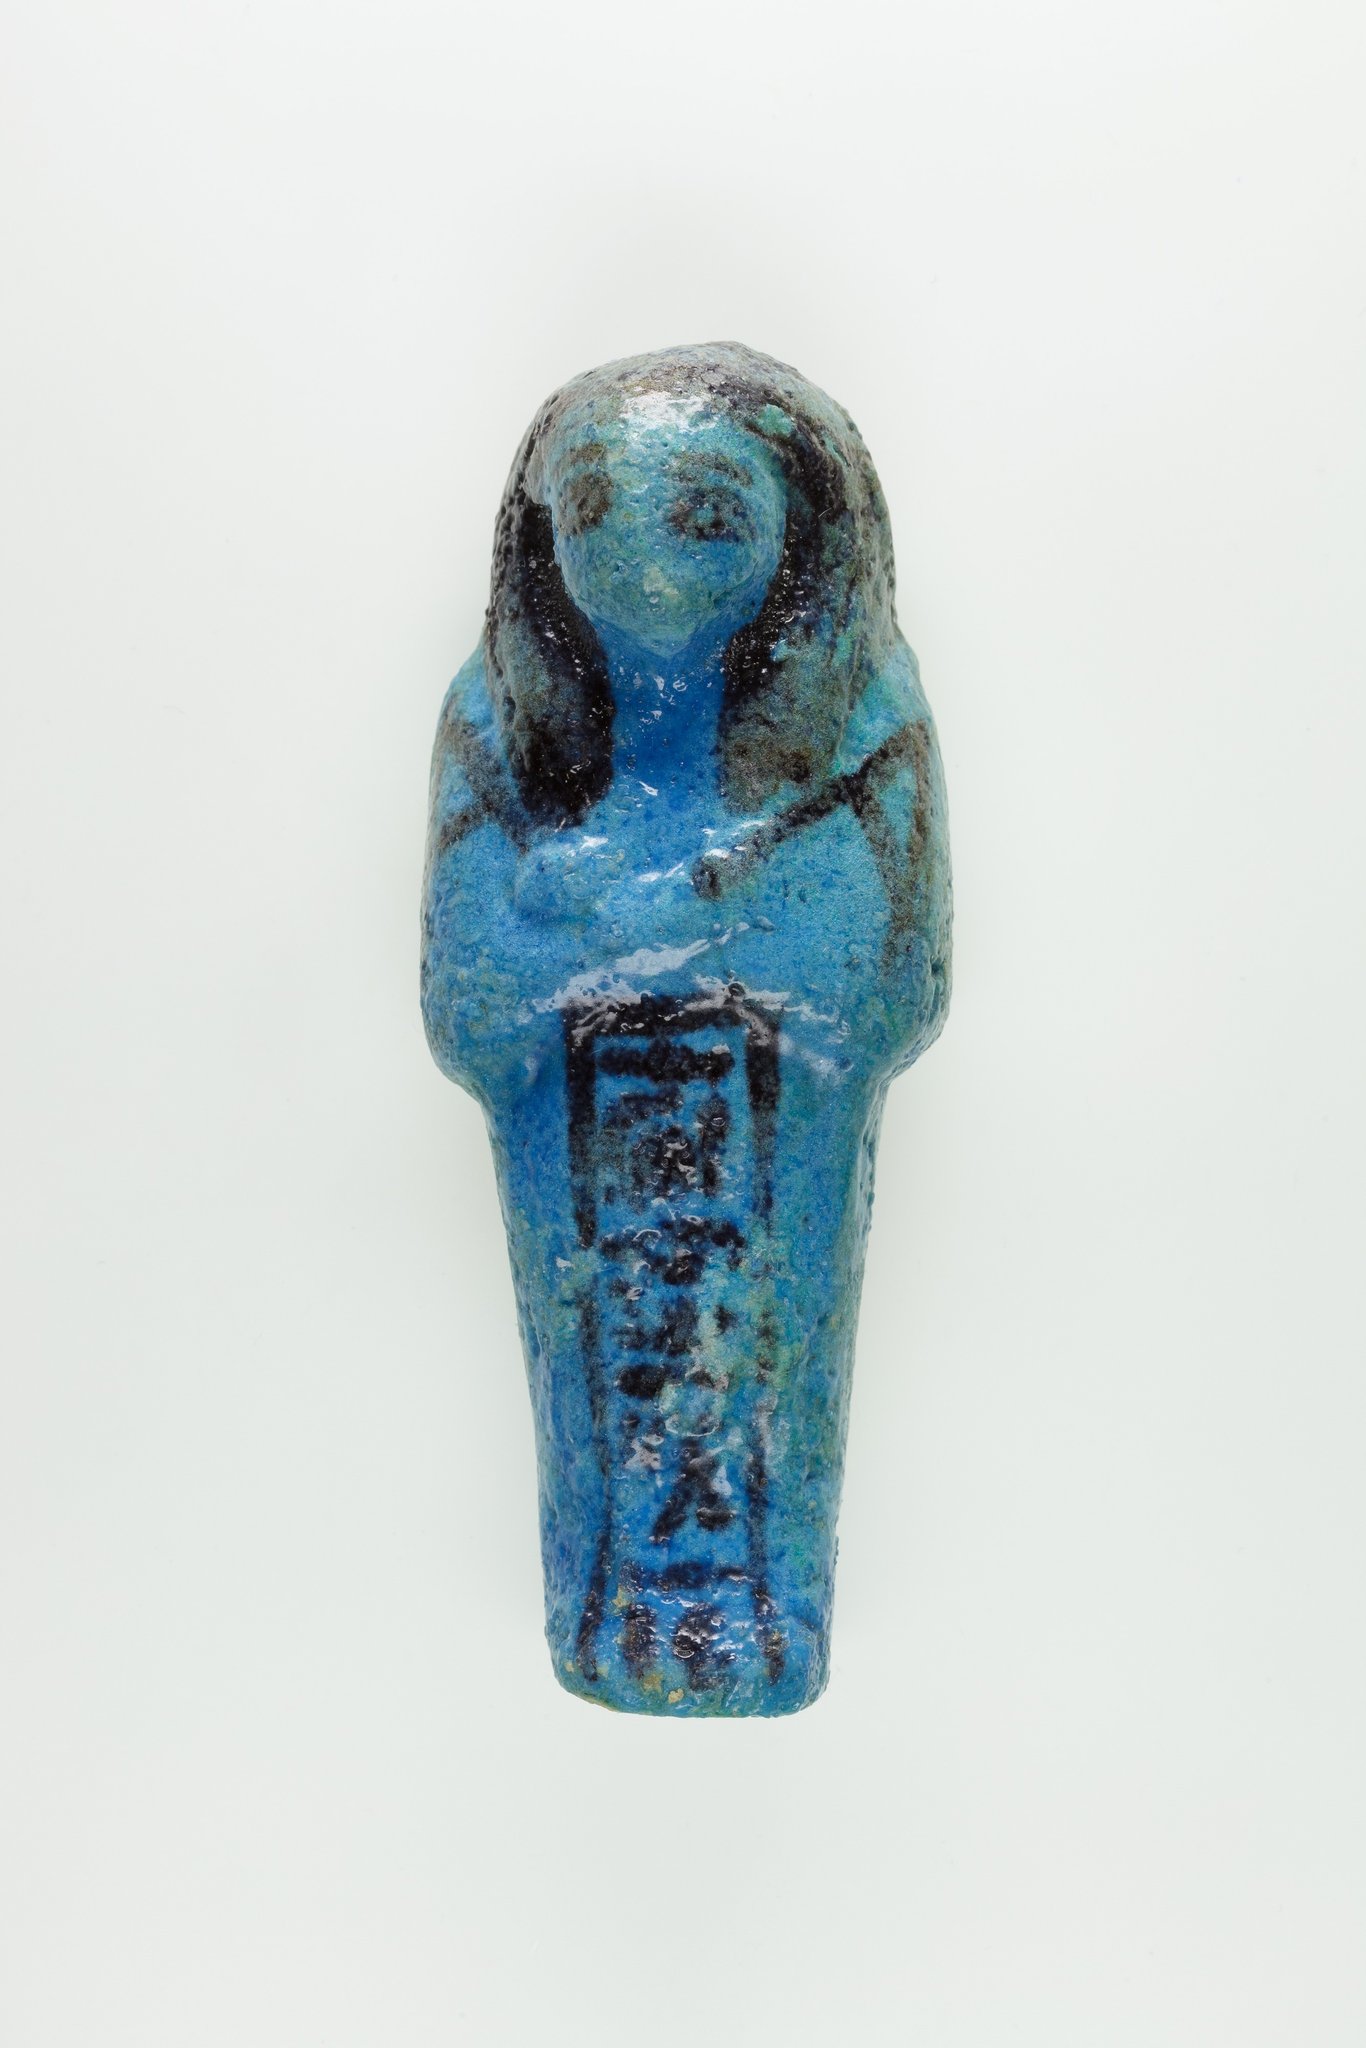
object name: shabti, worker, nauny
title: Worker Shabti of Nauny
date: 1050 BCE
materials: faience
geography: egypt